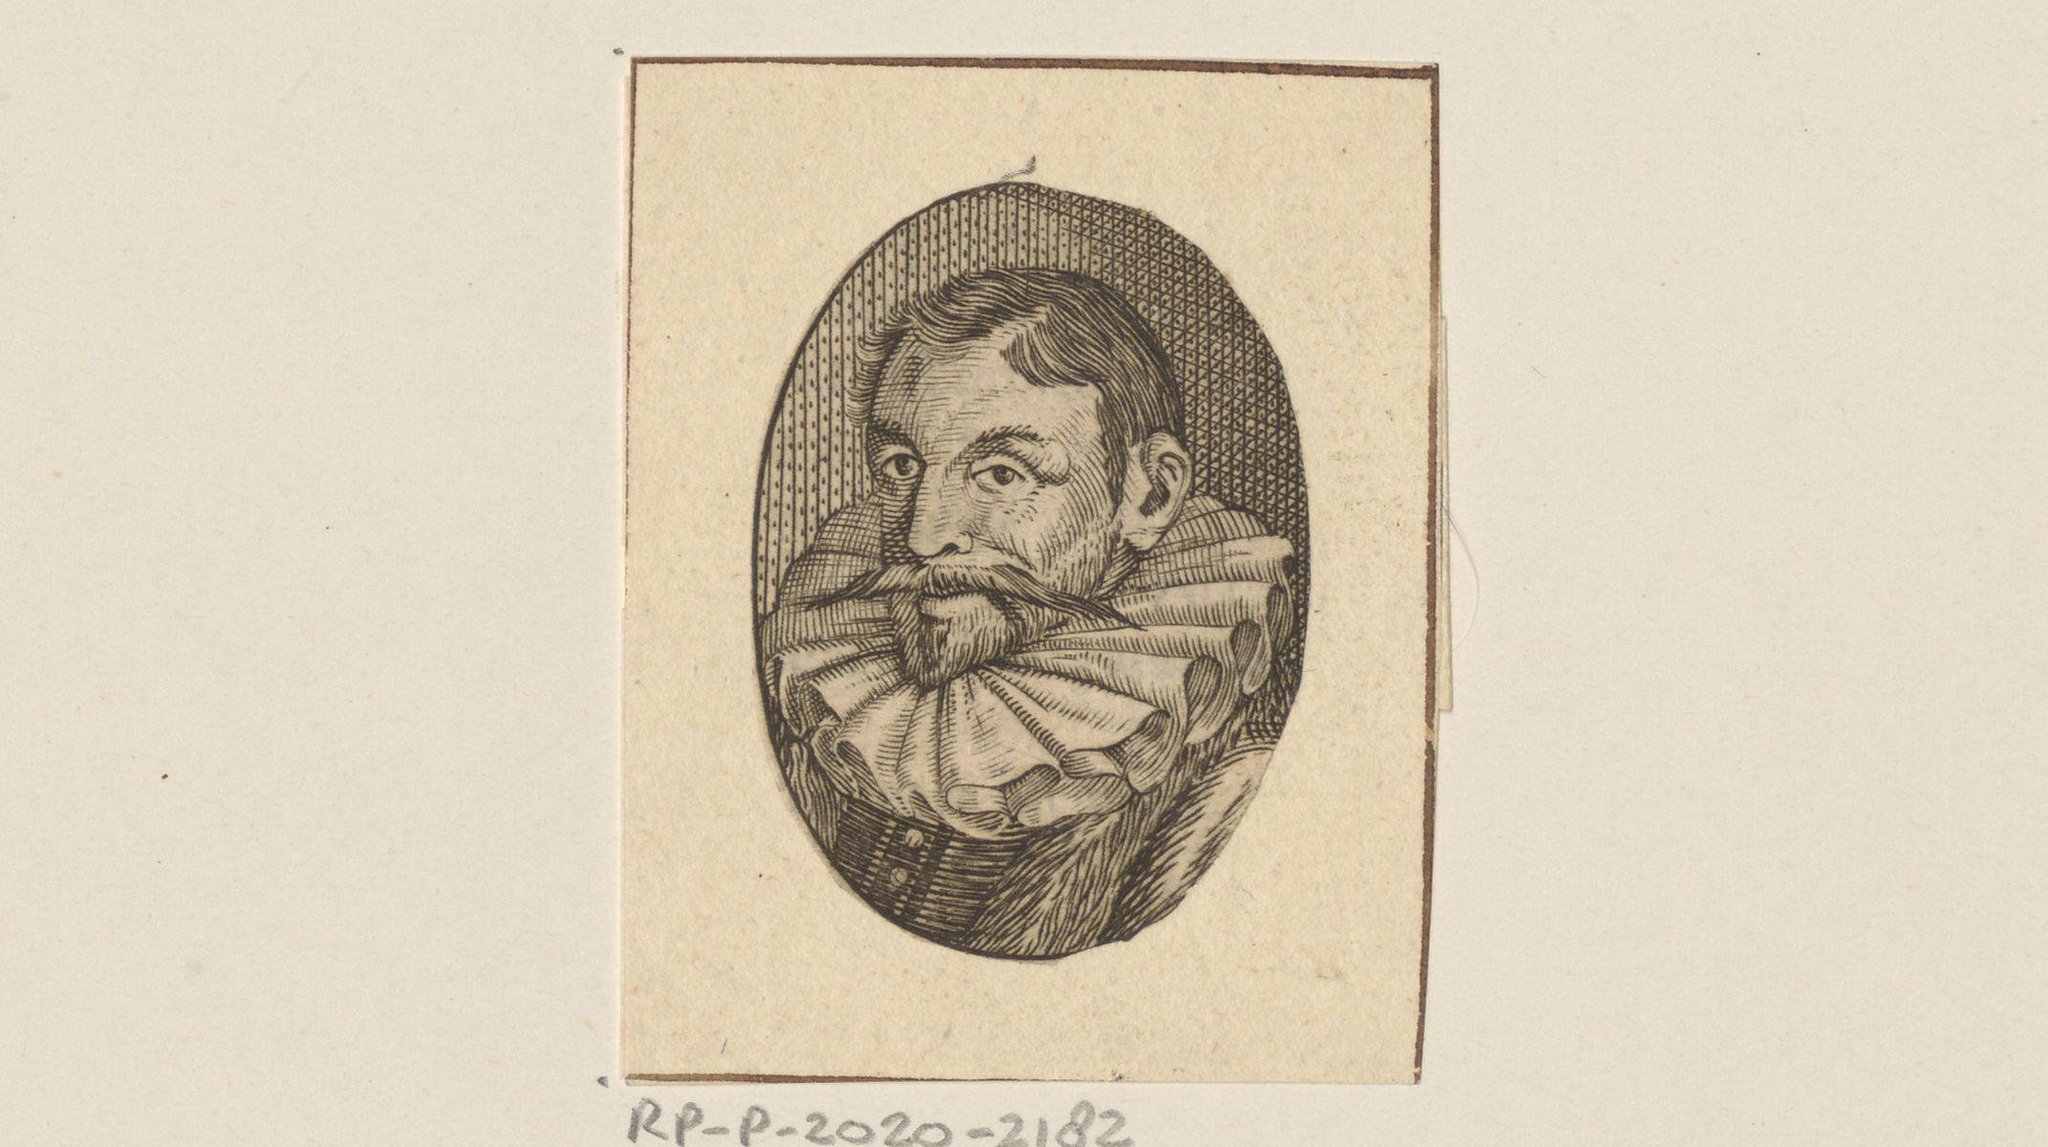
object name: book illustration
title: Portret van Jan van der Does, heer van Noordwijk en Kattendijke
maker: Anonymous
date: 1650-1699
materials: paper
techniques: engraving, letterpress printing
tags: commander-in-chief, general, marshal, historical persons, writer, poet, author